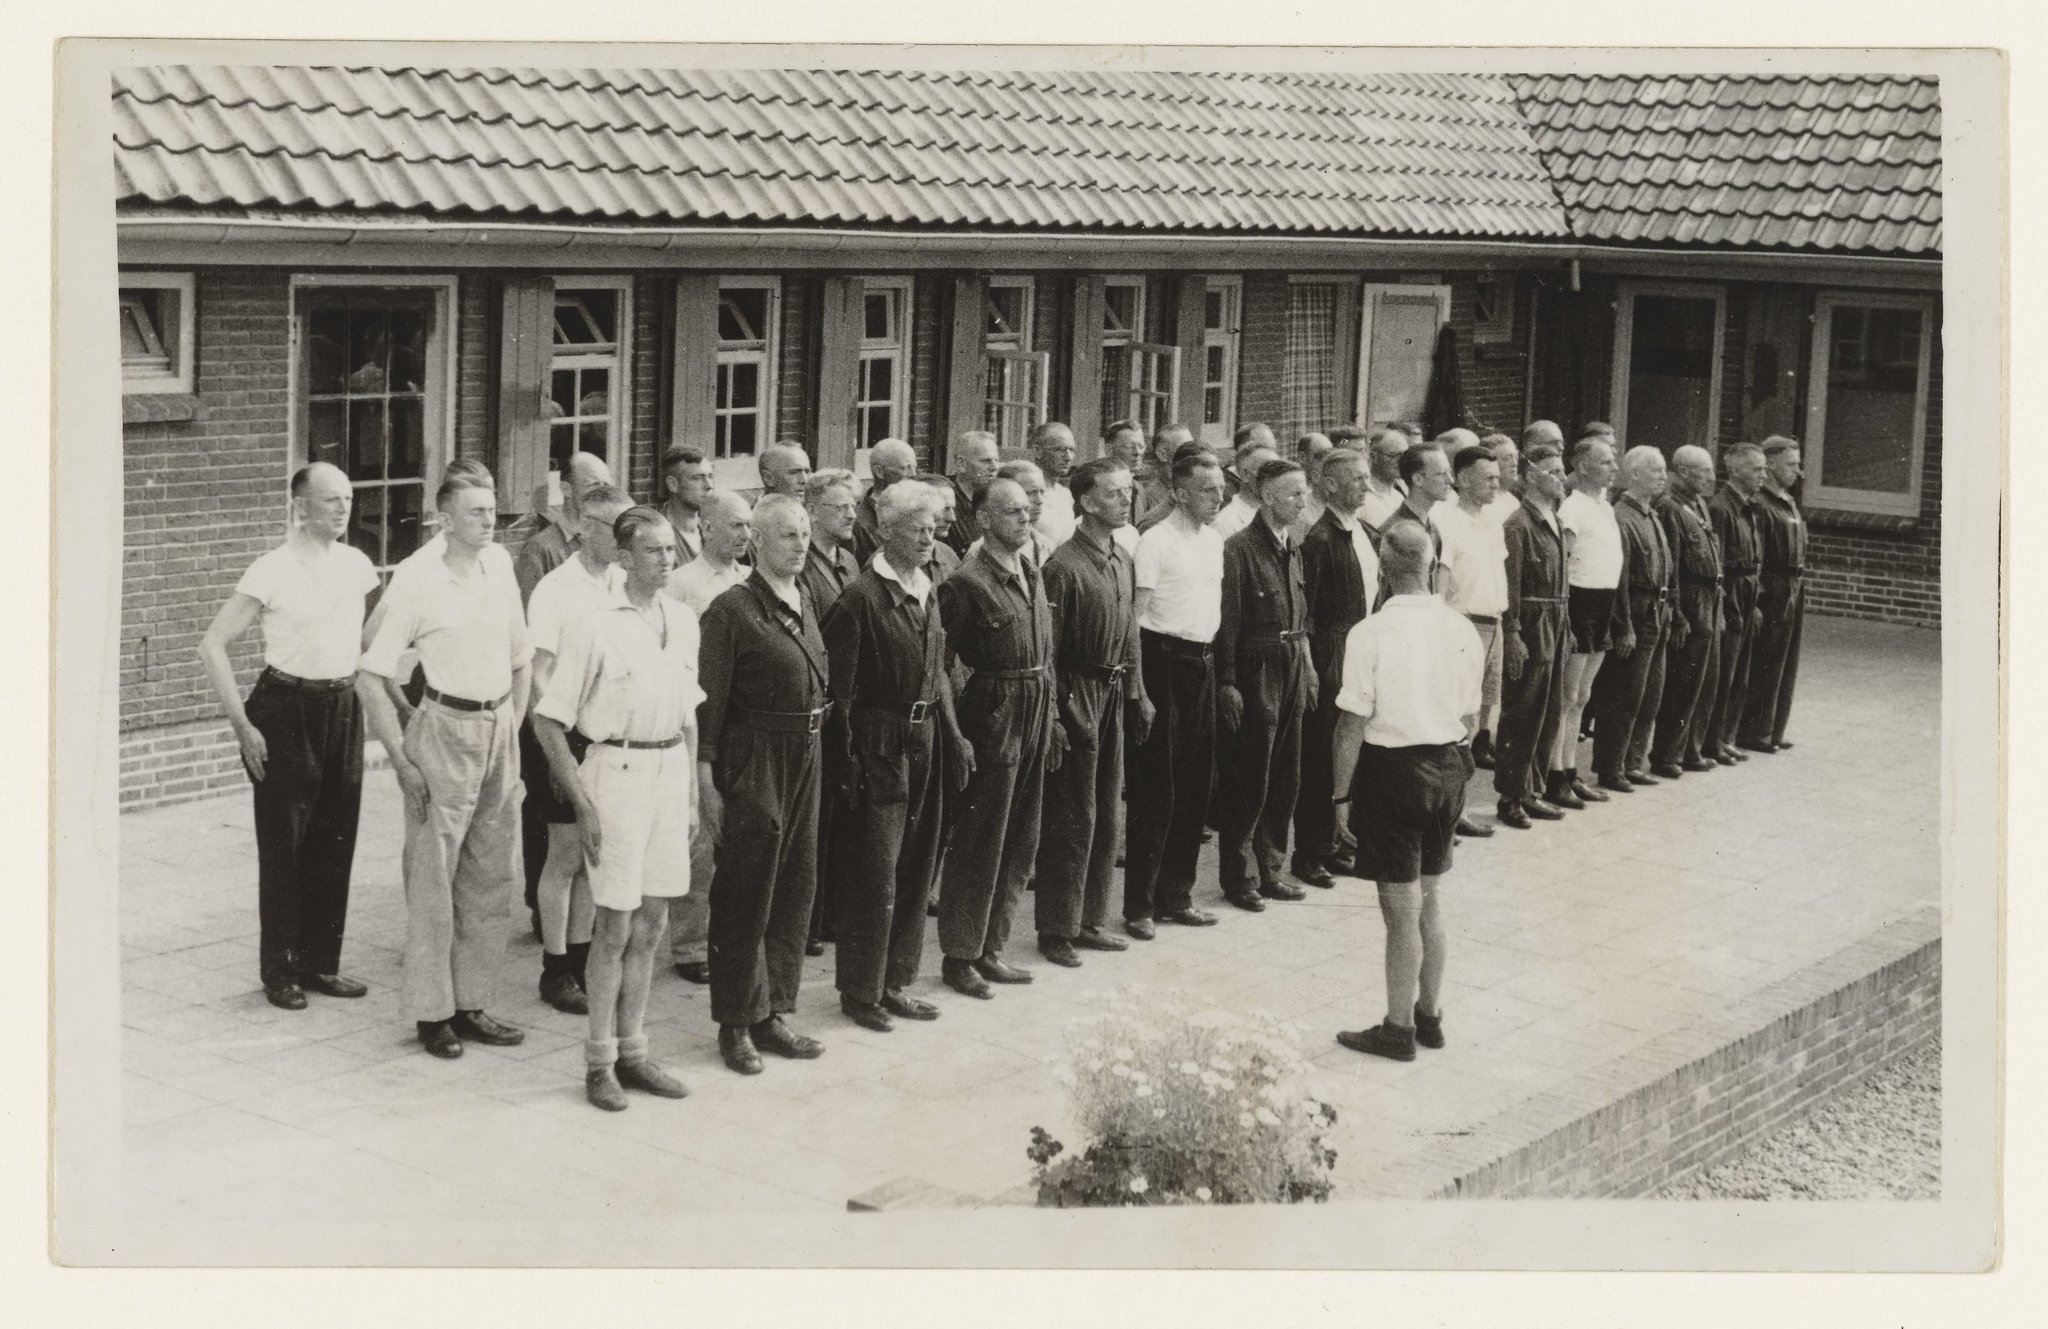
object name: photograph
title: Opleiding Landwacht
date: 1943-1944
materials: photographic support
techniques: photography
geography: lunteren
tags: military training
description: Drie rijen mannen staan opgesteld voor een gebouw. Vooraan mannen in overalls, sommige anderen in korte broek of lange broek. Op de rug gezien een man in korte broek. De mannen worden opgeleid op de Scheleberg in Lunteren voor de Landwacht. Opgericht in november 1943 als beschermingsorganisatie voor de NSB na een aantal aanslagen op vooraanstaande NSBers. Al snel kwam de Landwacht onder controle van de Duitsers en werd ook als hulppolitie ingezet. De Scheleberg werd gebouwd in 1936 als vakantieoord voor leden van de Algemeene bond voor handels- en kantoor bedienden.